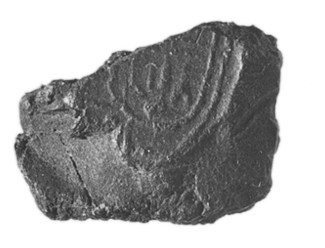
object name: sealing fragment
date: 2030-1640 BCE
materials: clay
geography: egypt